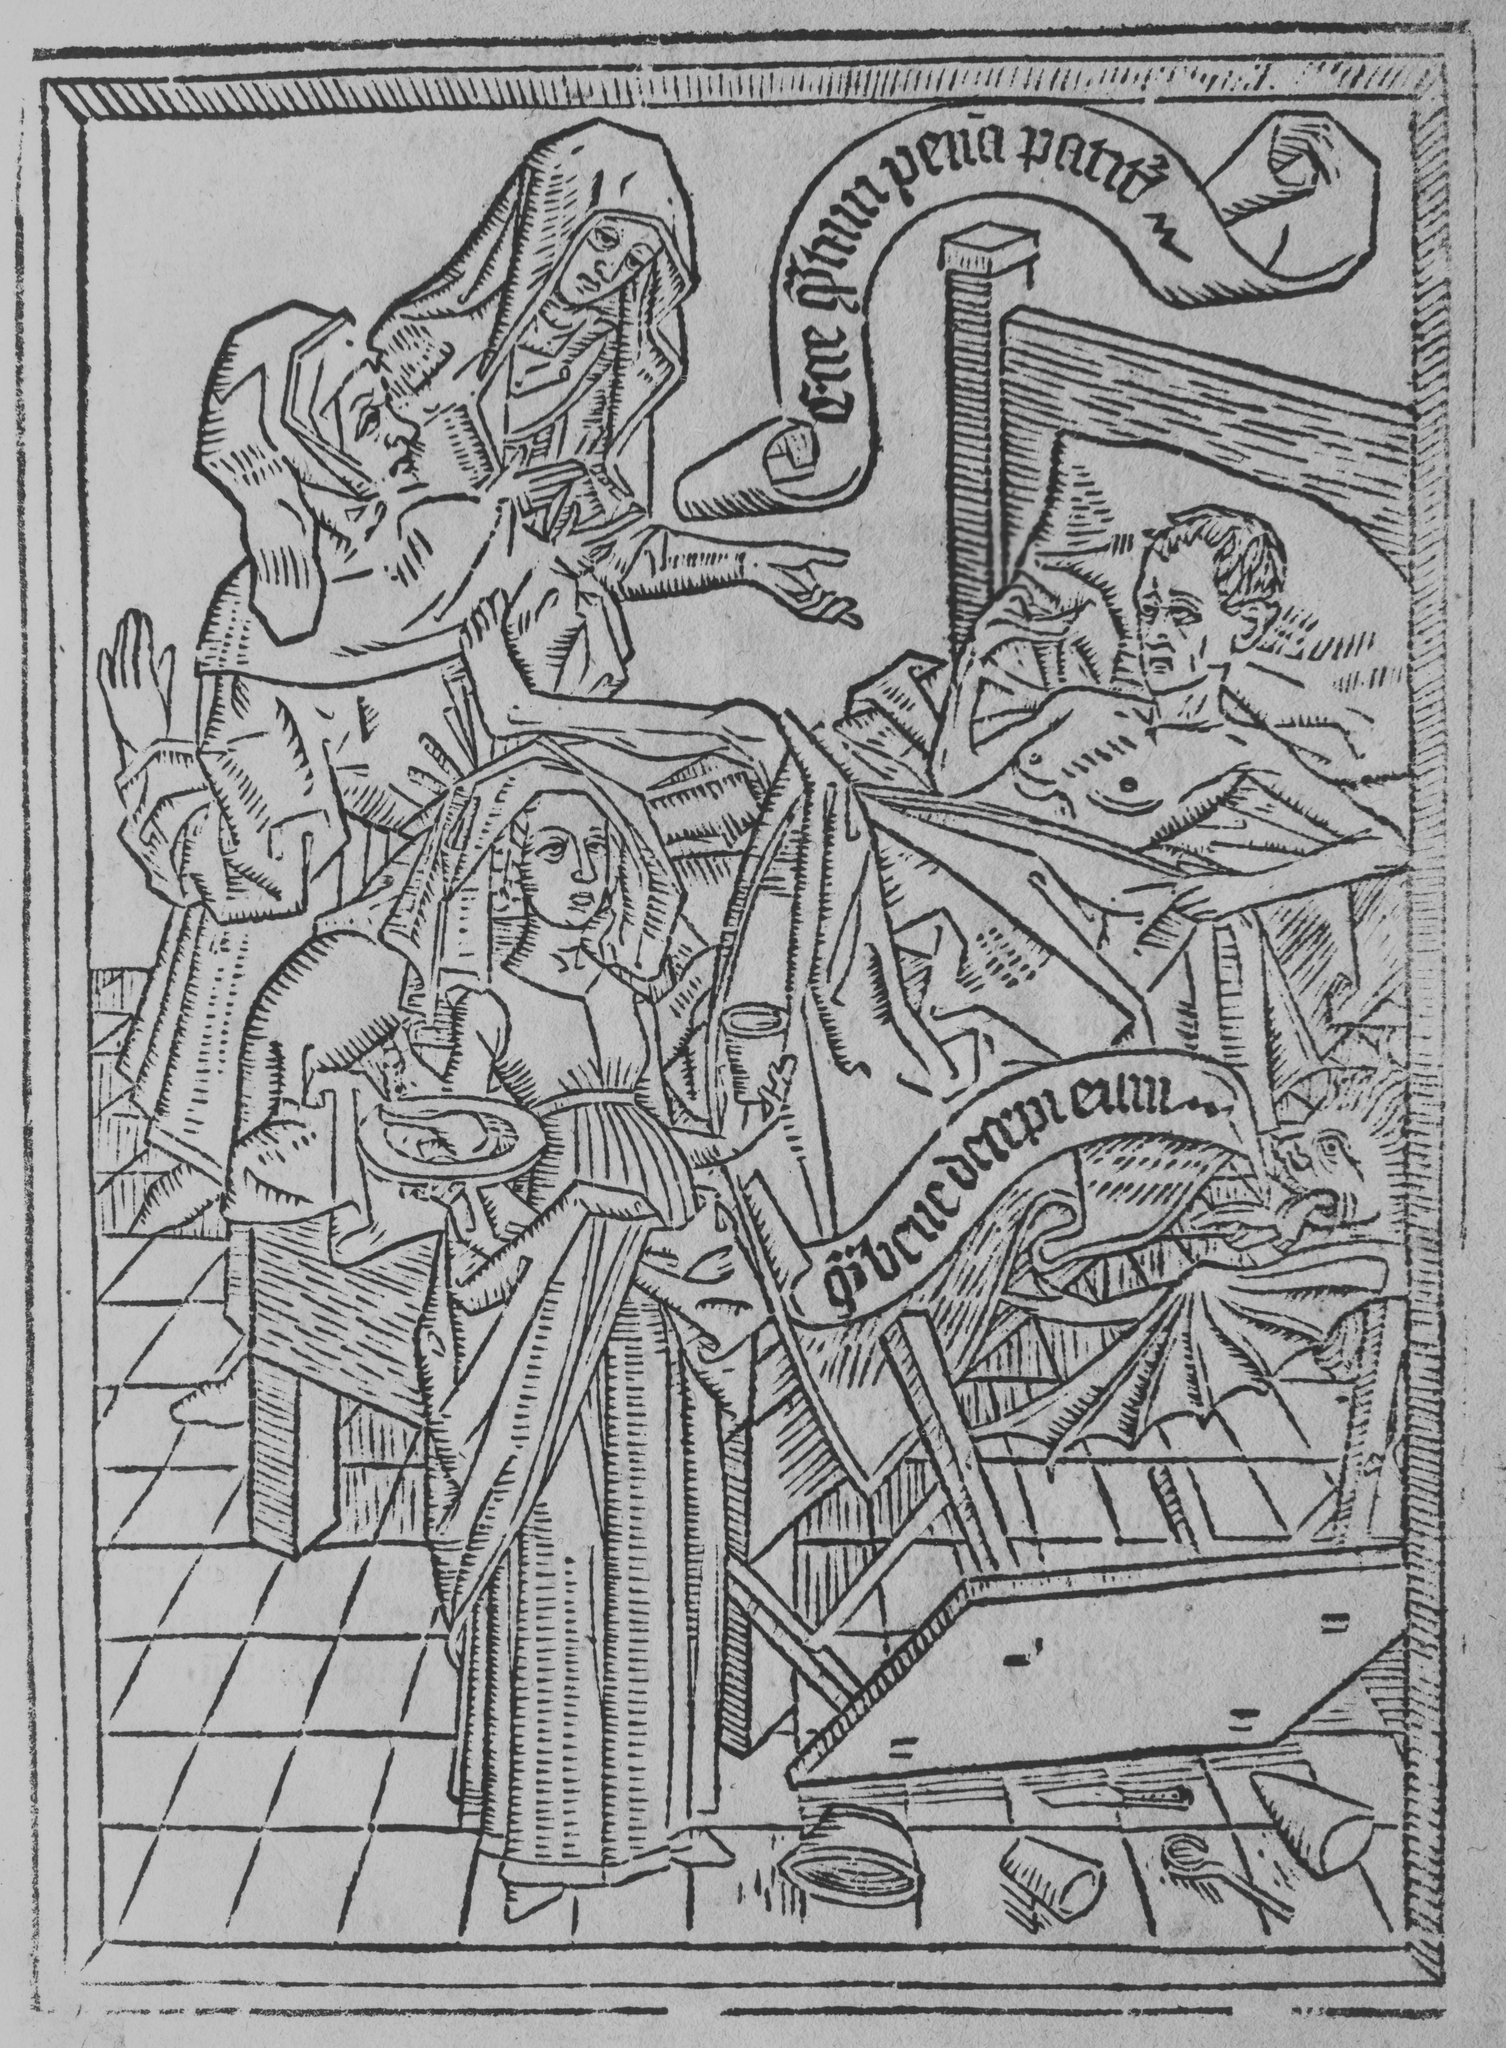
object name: book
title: Ars Moriendi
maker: nicolaus gotz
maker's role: publisher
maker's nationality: german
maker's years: 1474-1480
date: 1475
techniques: woodcut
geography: germany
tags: illness,men,women